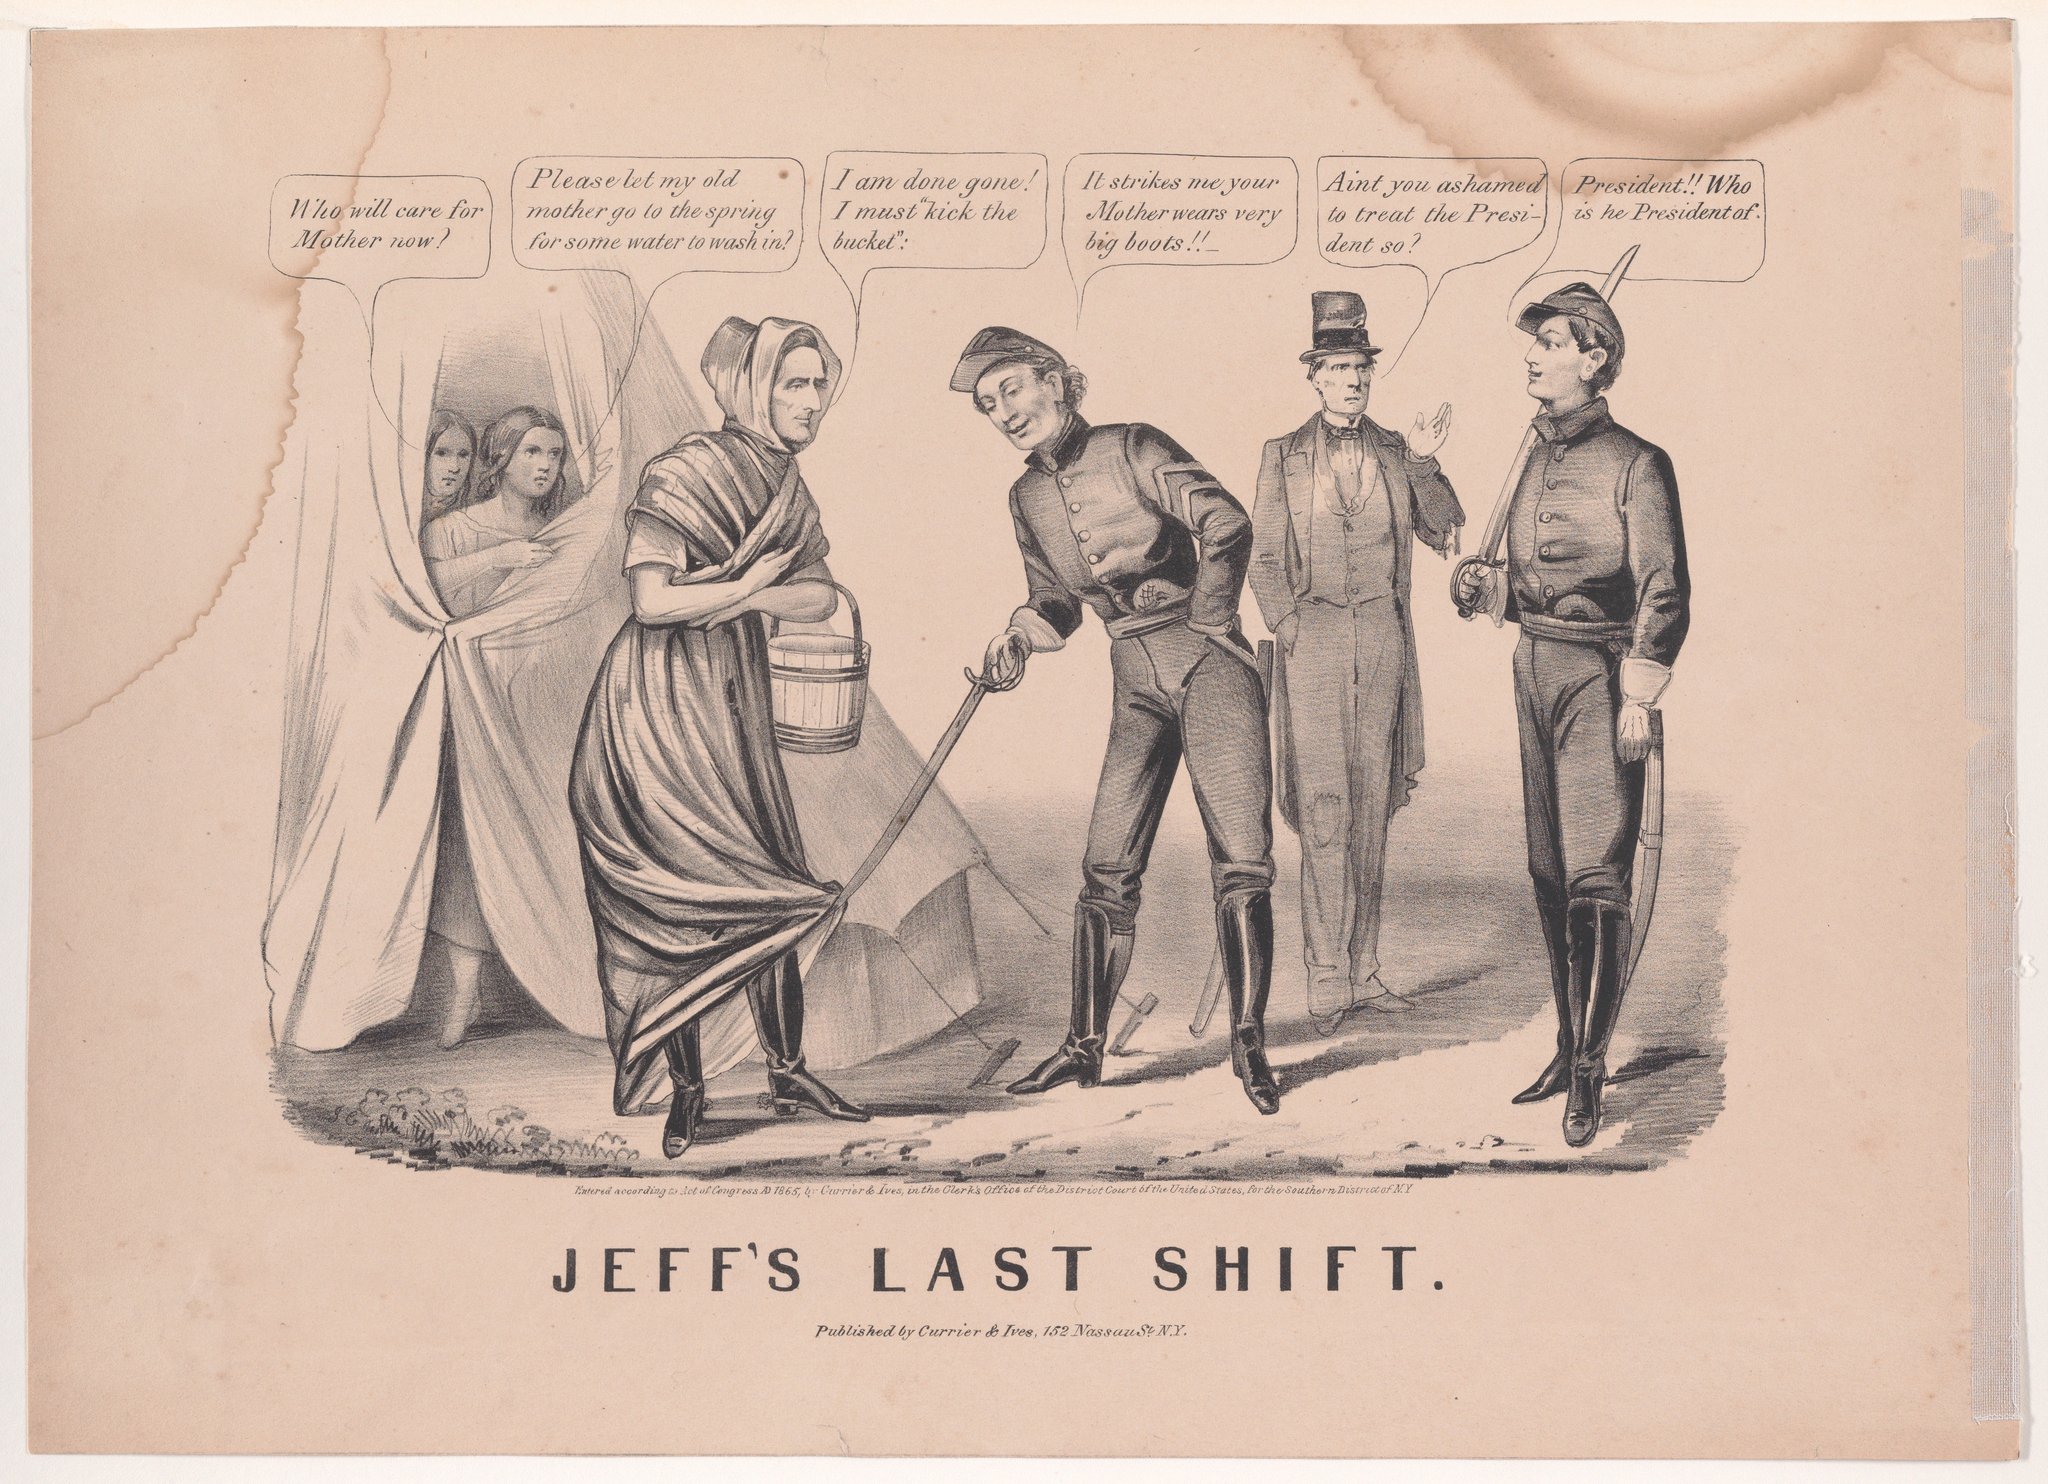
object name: print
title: Jeff's Last Shift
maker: john cameron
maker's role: artist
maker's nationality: american, born scotland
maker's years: 1828-1896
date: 1865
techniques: lithograph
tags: satire,tents,american civil war,men,women